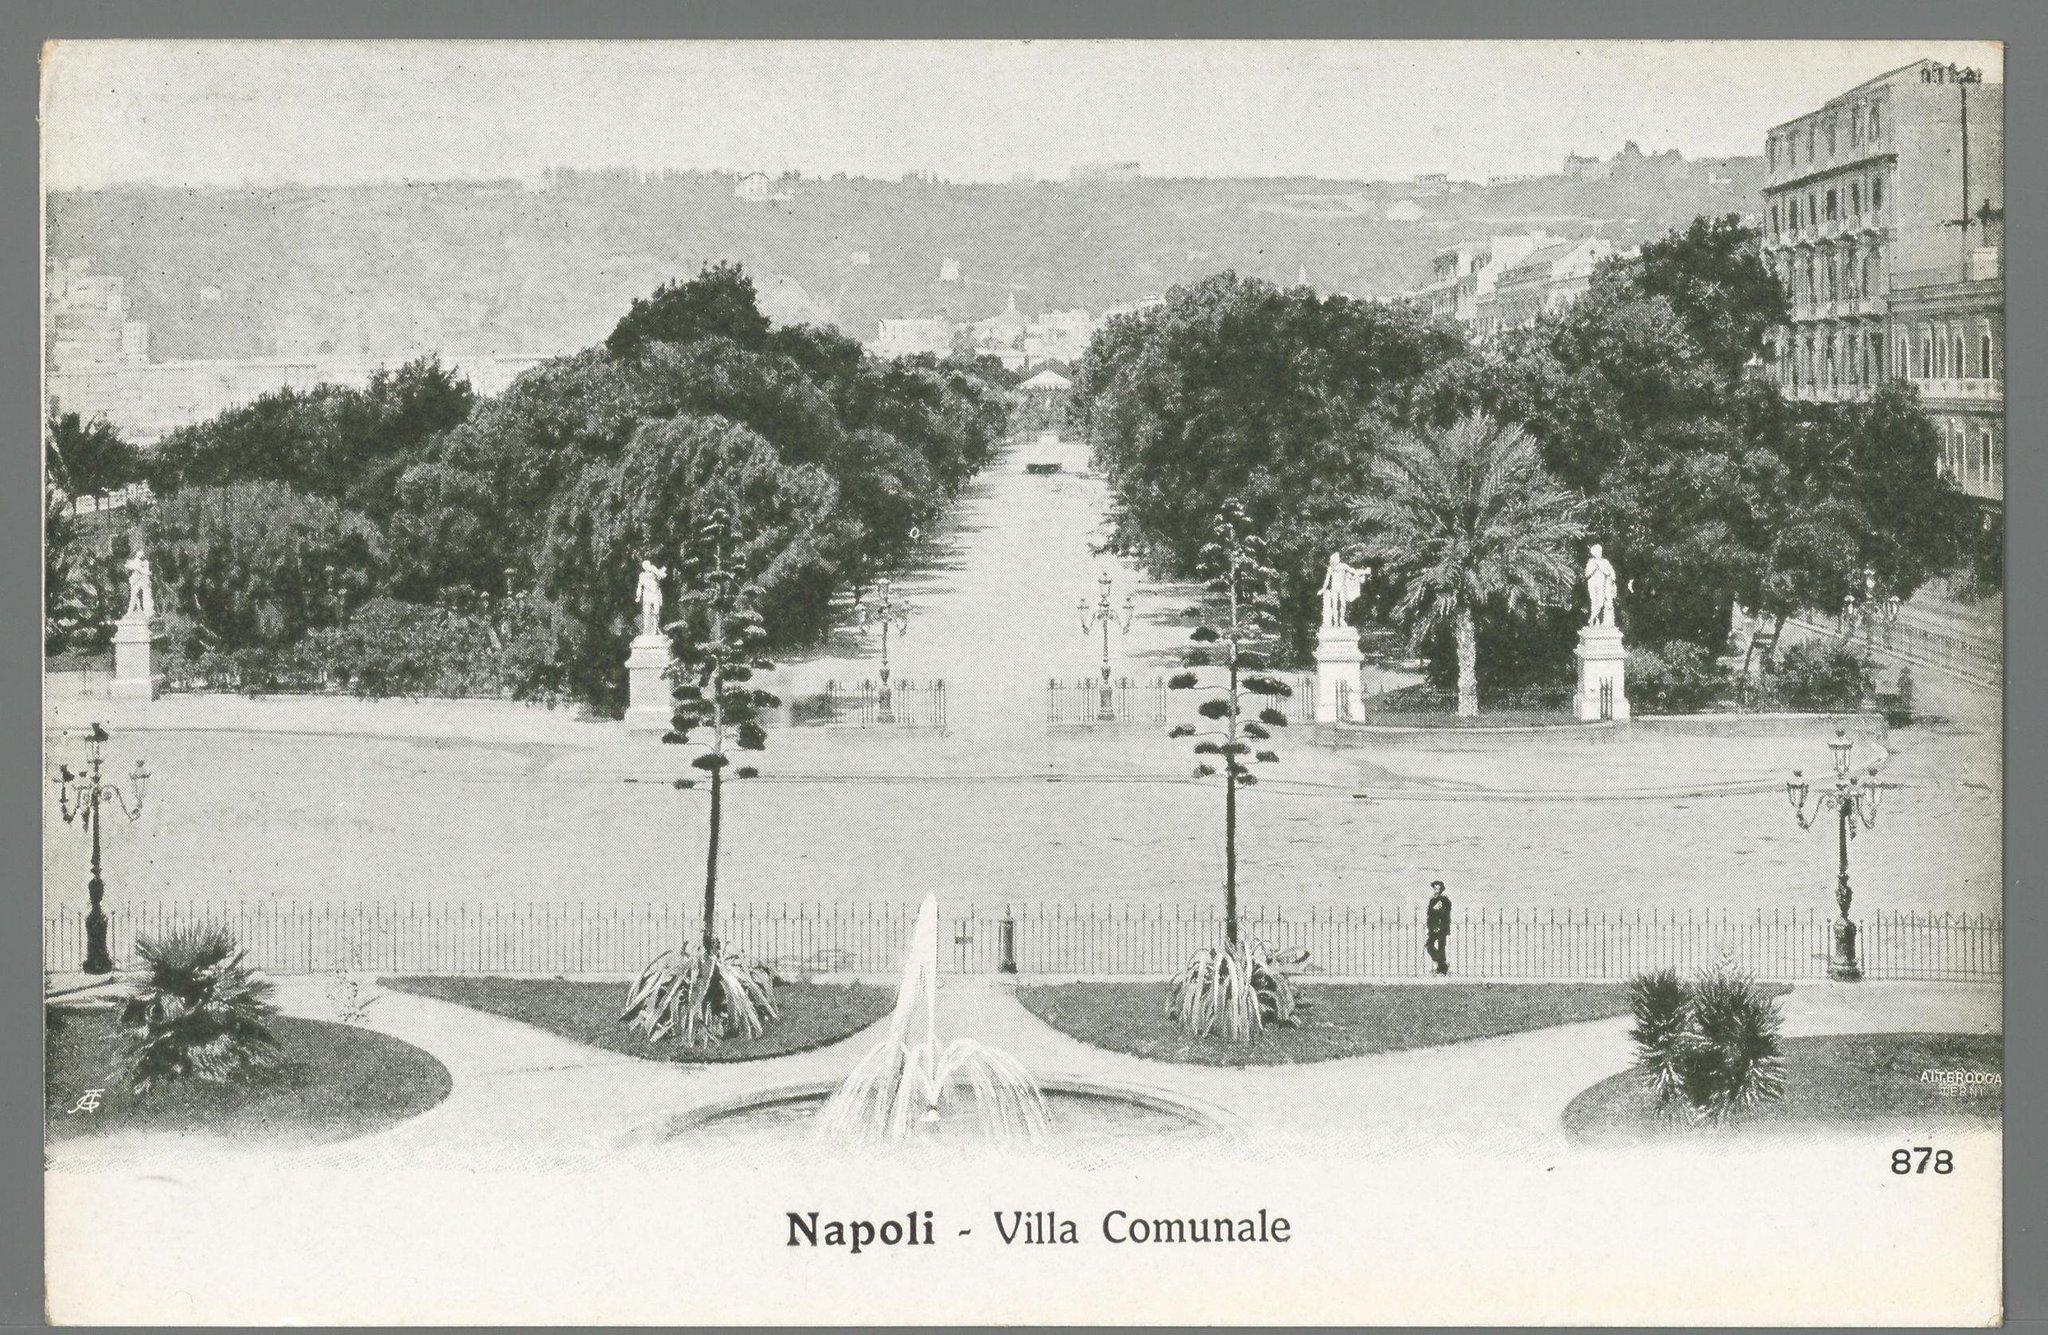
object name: ansichtkaart, prentbriefkaart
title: Napoli. Villa Comunale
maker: Anonymous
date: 1906-1910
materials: cardboard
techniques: autotype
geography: naples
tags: public gardens, park (+ city(-scape) with figures, staffage), city-view, and landscape with man-made constructions (+ city(-scape) with figures, staffage)